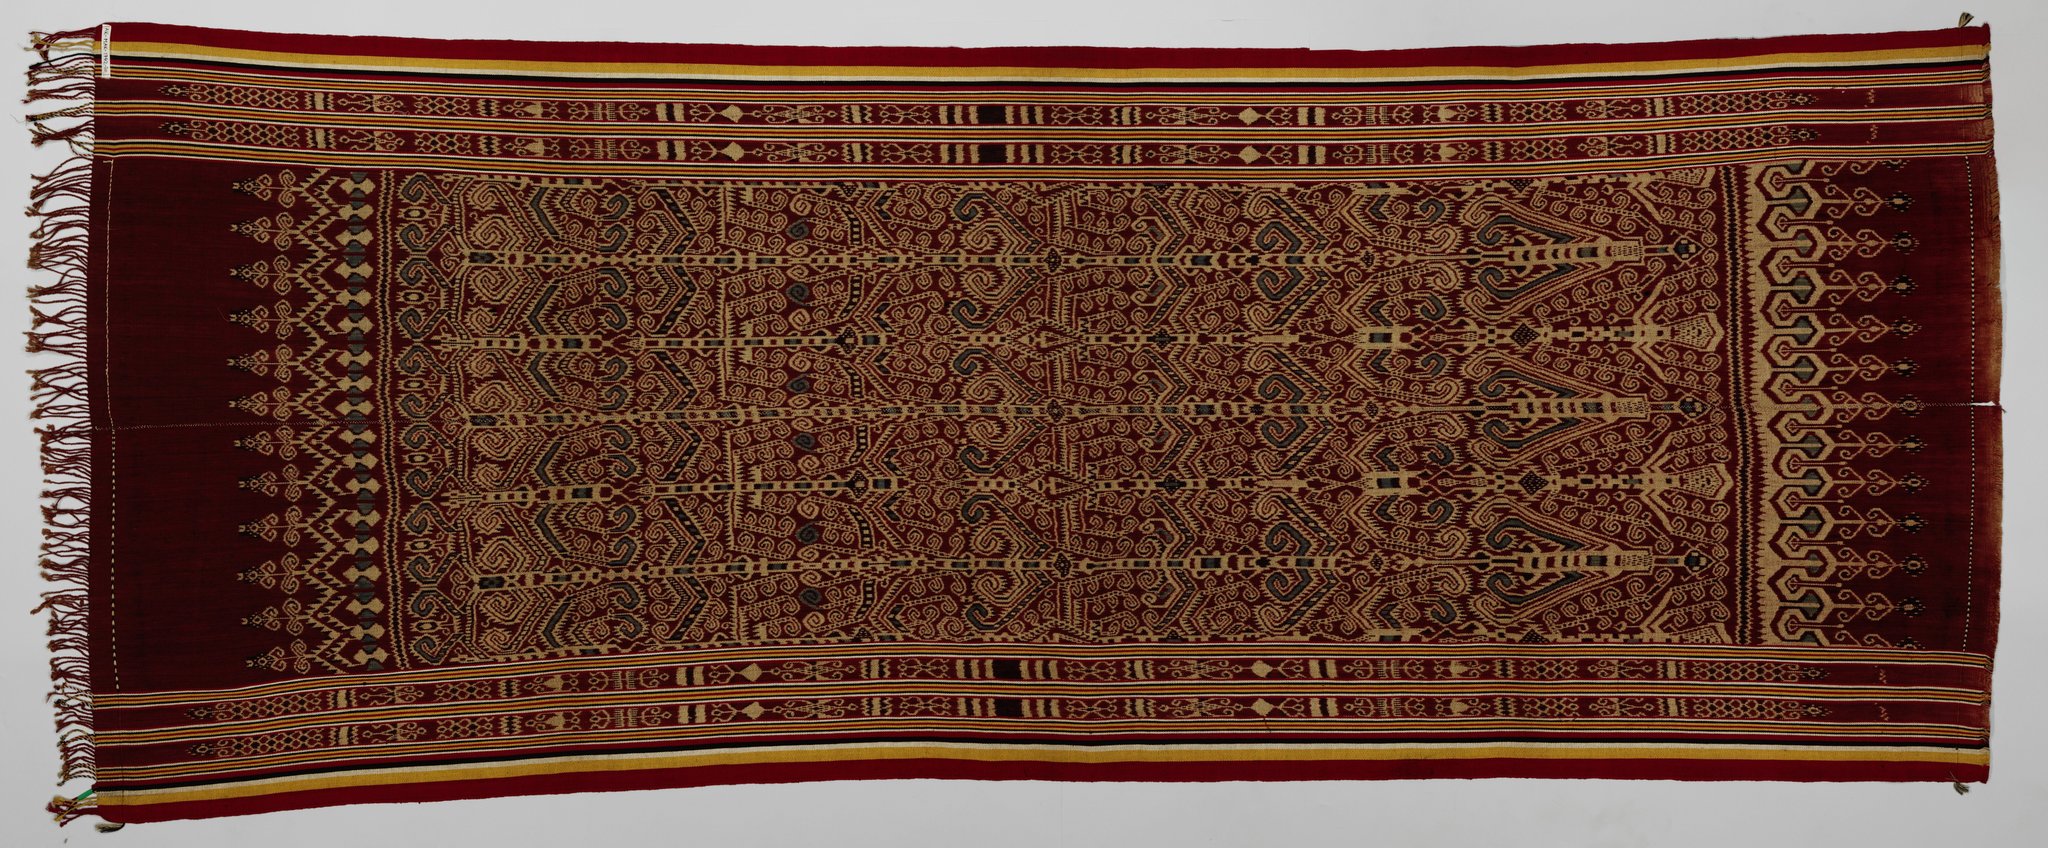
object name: cloth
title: Doek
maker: Anonymous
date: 1925-1975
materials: cotton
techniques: weave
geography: sarawak